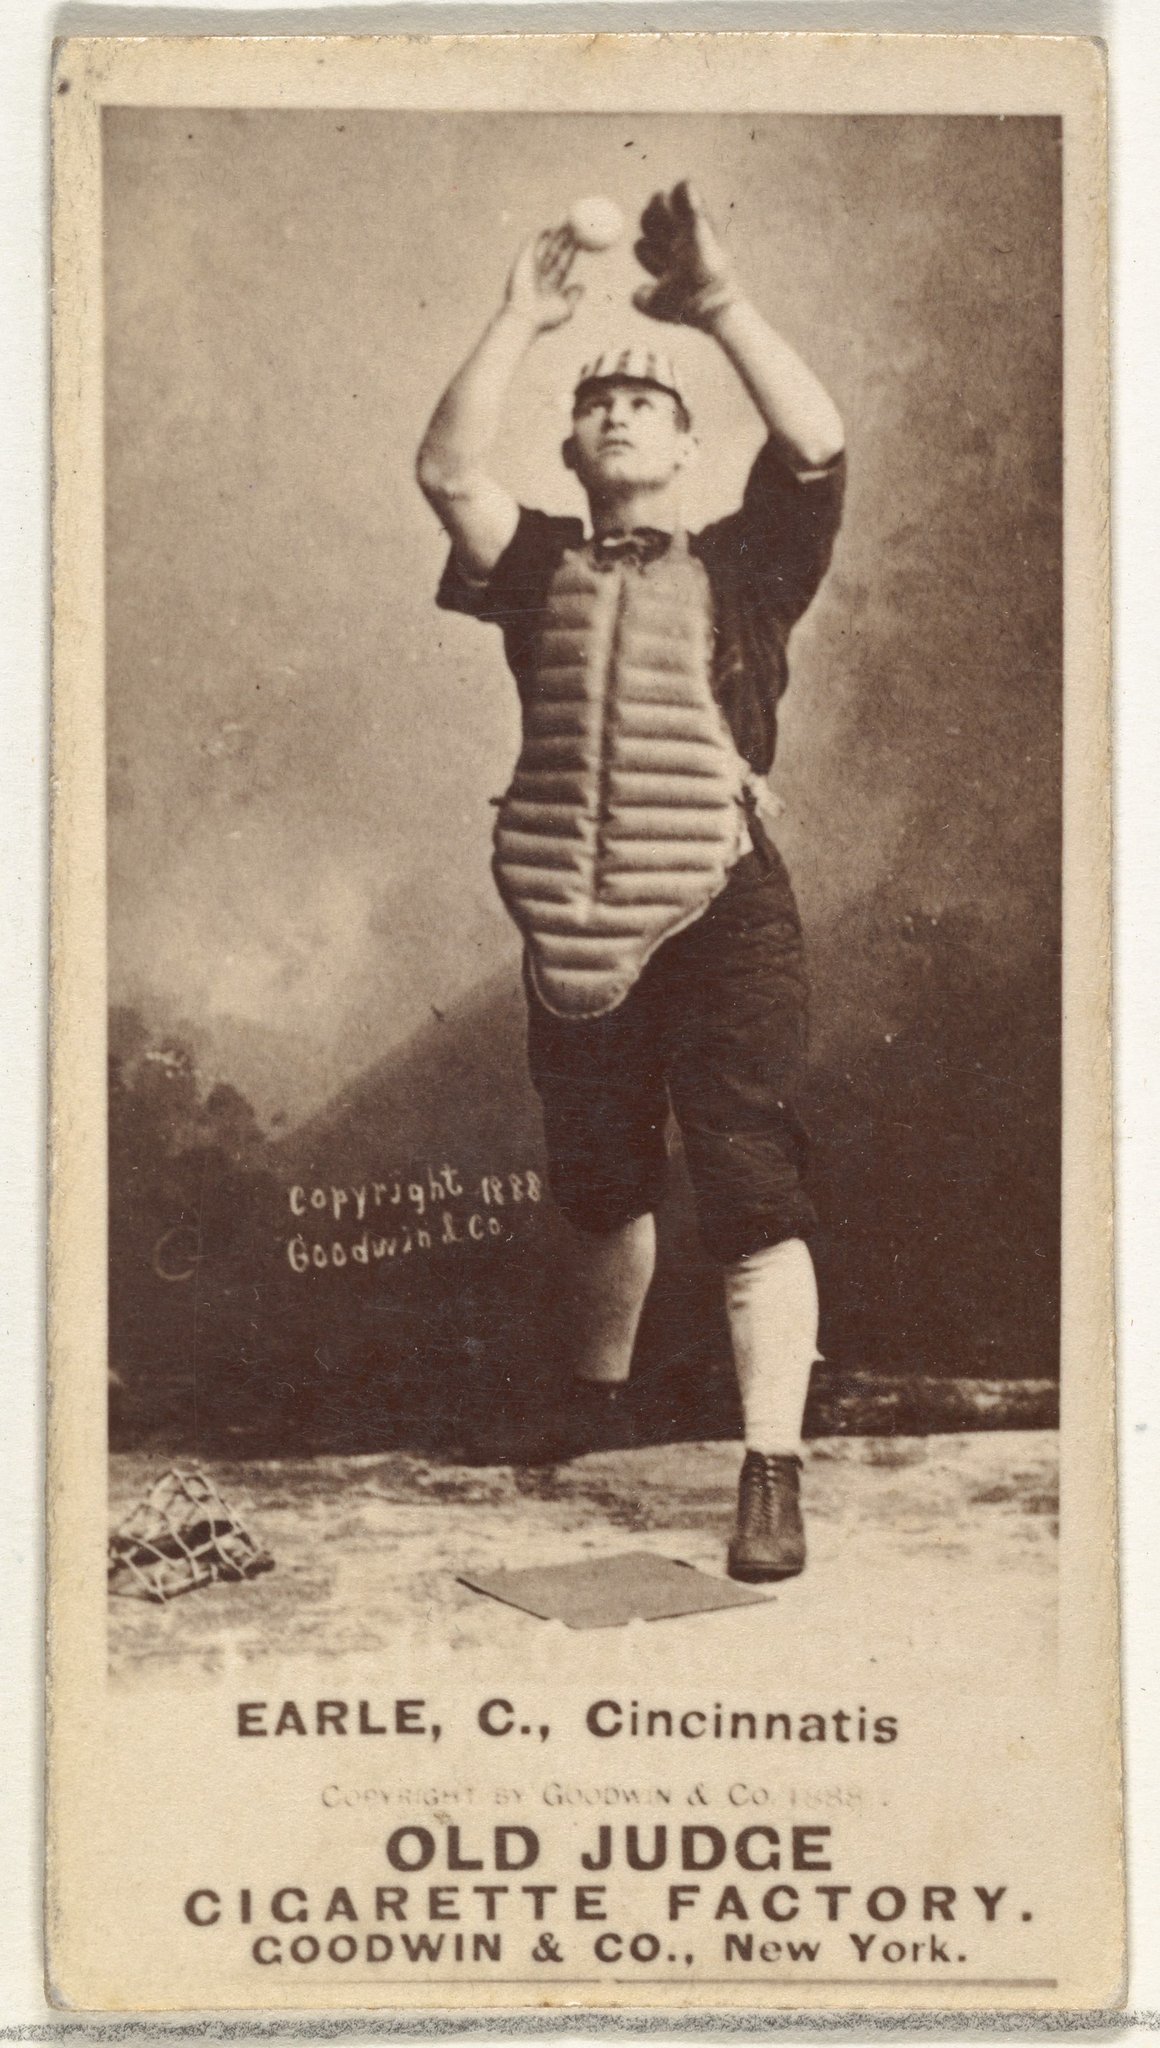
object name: baseball card, photograph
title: William Moffat "Billy" Earle, Catcher, Cincinnati, from the Old Judge series (N172) for Old Judge Cigarettes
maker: goodwin & company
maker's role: publisher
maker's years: 1850-1950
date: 1888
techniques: albumen silver print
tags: men,portraits,baseball,athletes